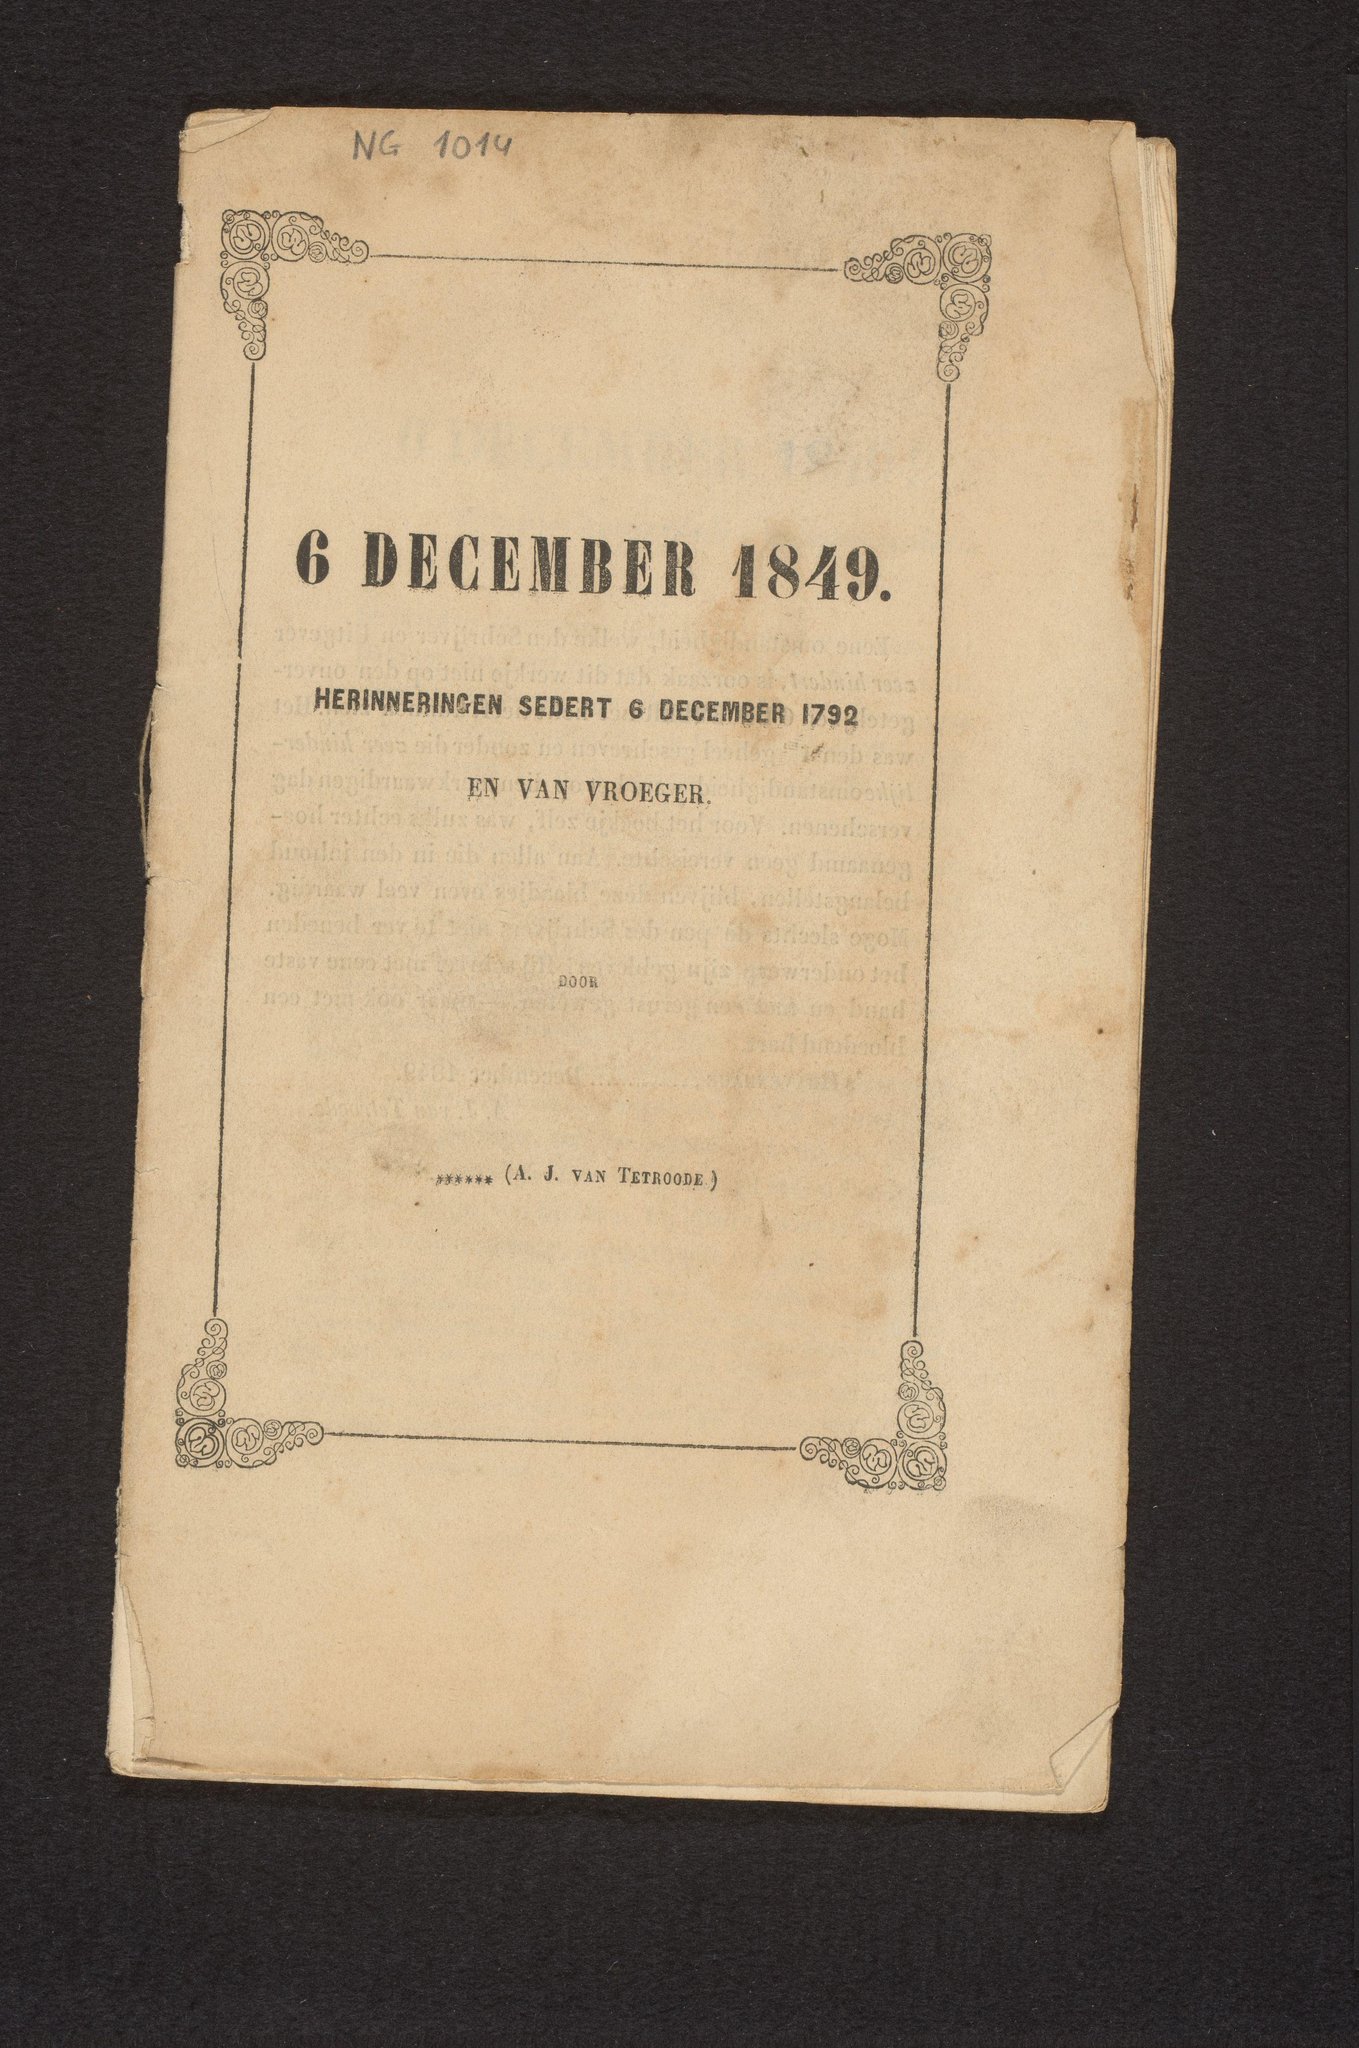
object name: brochure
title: 6 december 1849, Herinneringen sedert 6 december 1792 en van vroeger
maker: anthonius johannes van tetroode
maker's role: printer, publisher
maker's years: 1795-1875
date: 1812-1849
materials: paper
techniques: printing, sewing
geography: the hague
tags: the hague, william ii of the netherlands, netherlands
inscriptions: date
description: 16 genummerde pp in papieren omslag waarop titel in kader. Gedateerd; laatste pagina: December 1849.